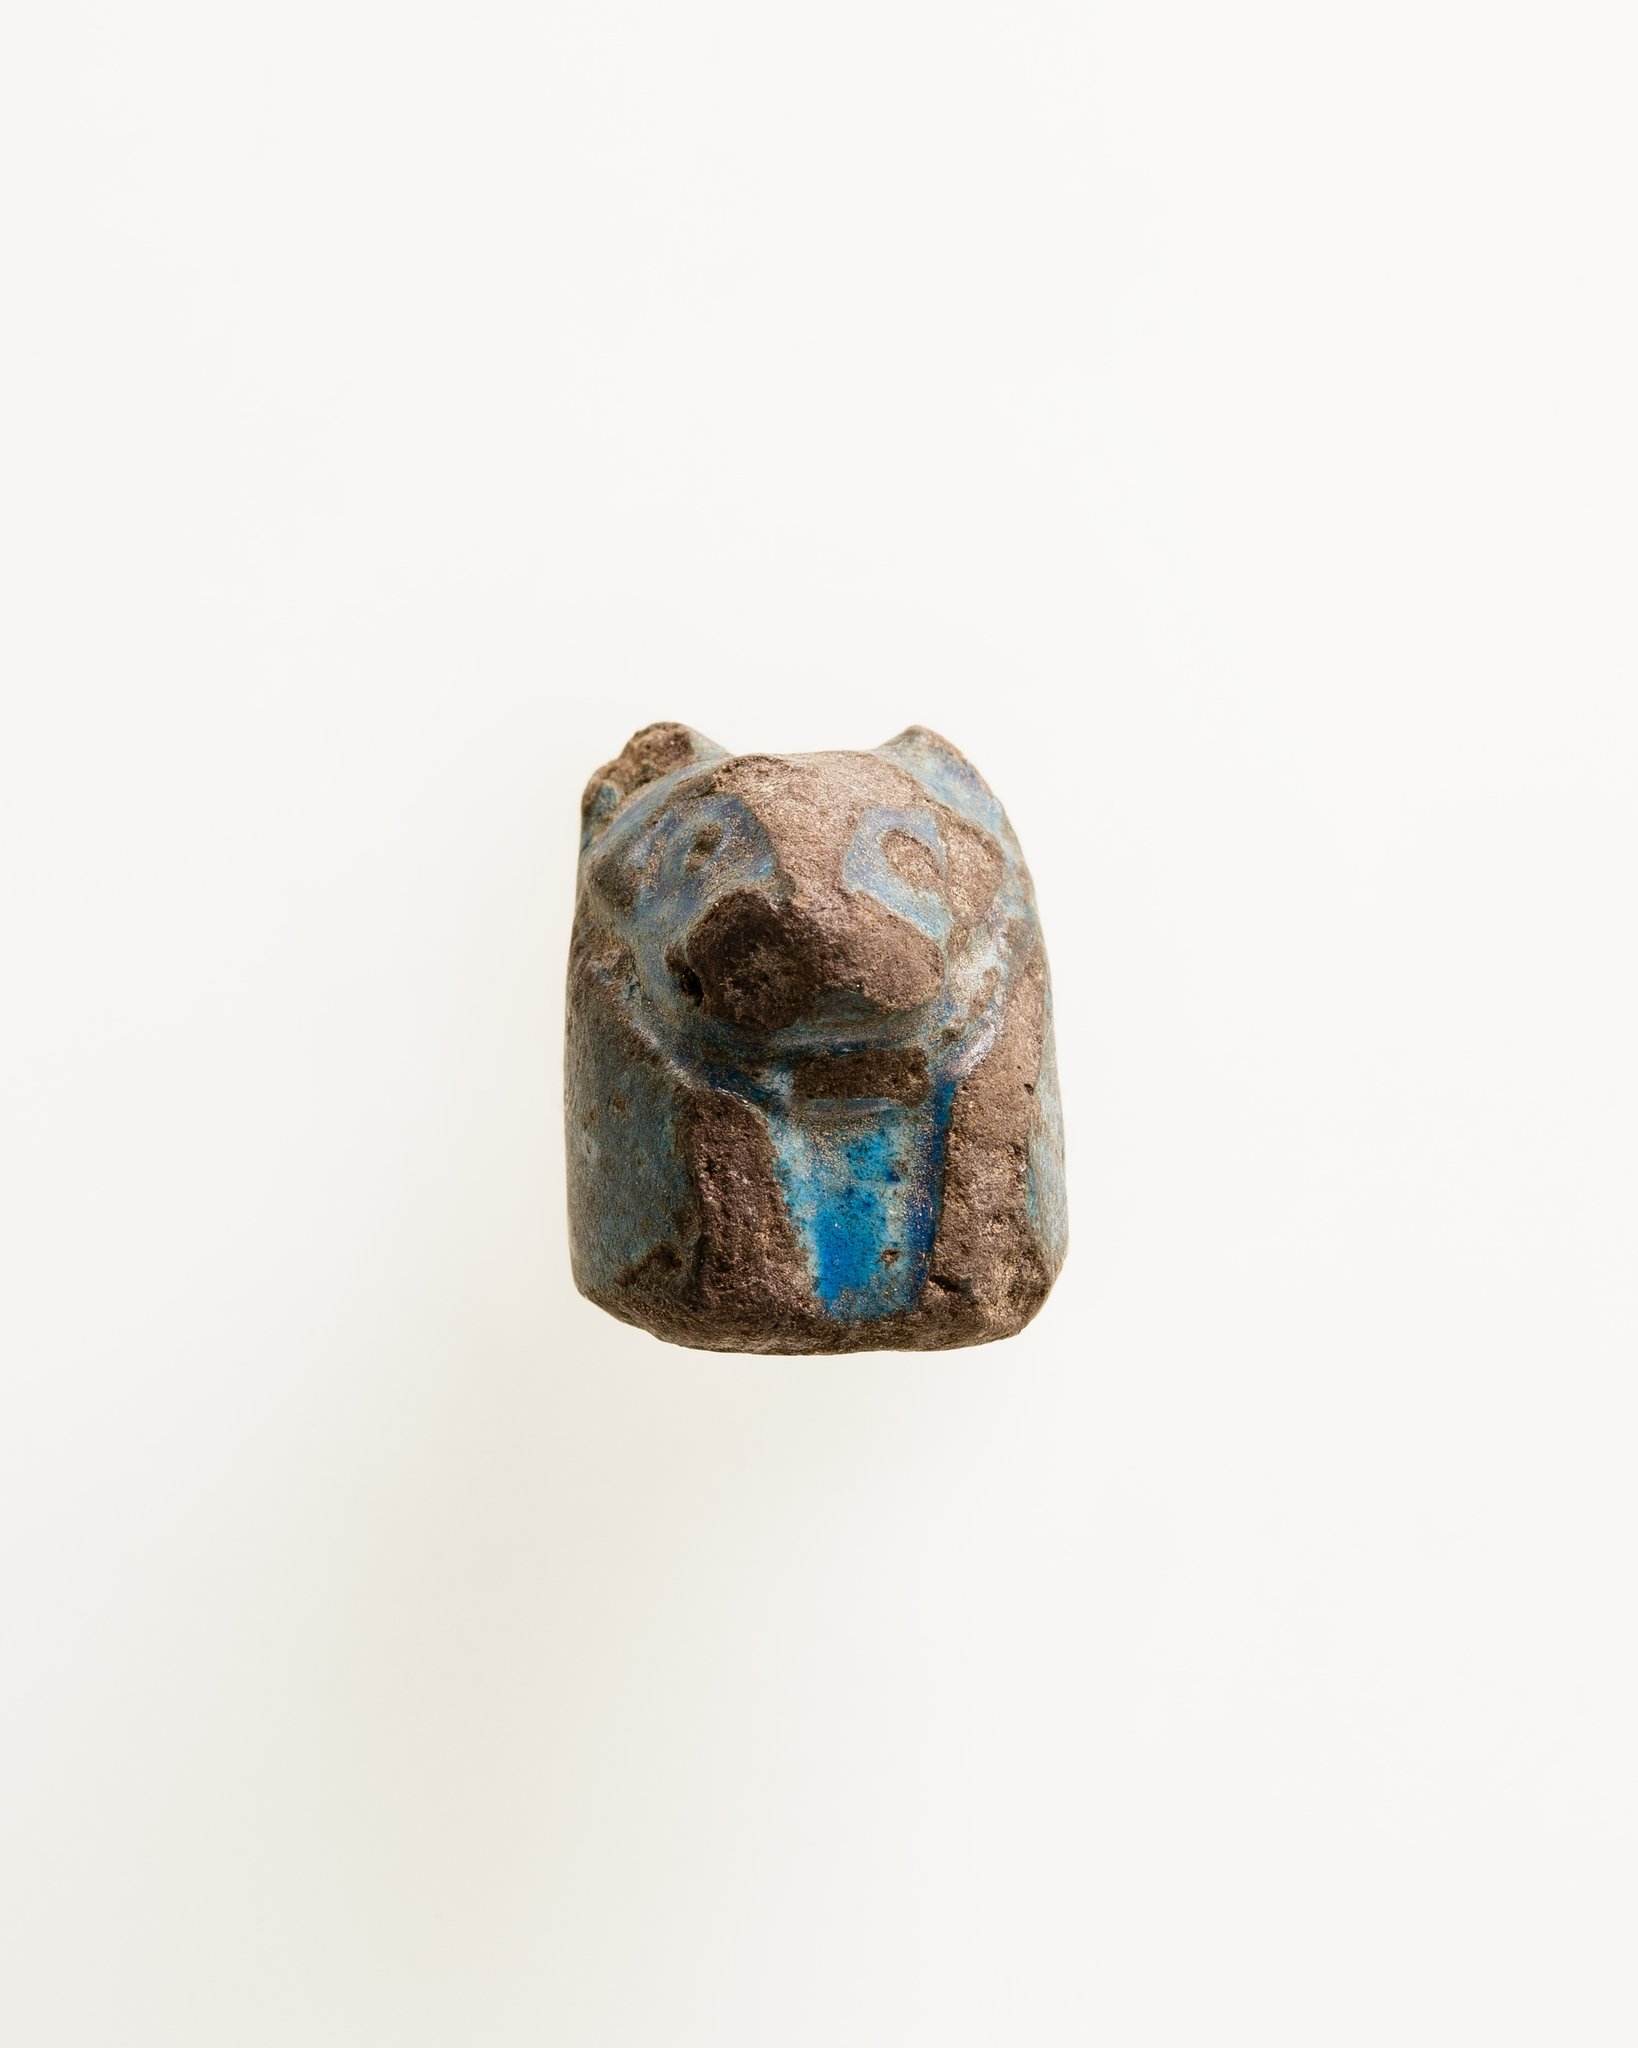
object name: game piece with lion head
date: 1070-525 BCE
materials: faience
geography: egypt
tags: lions